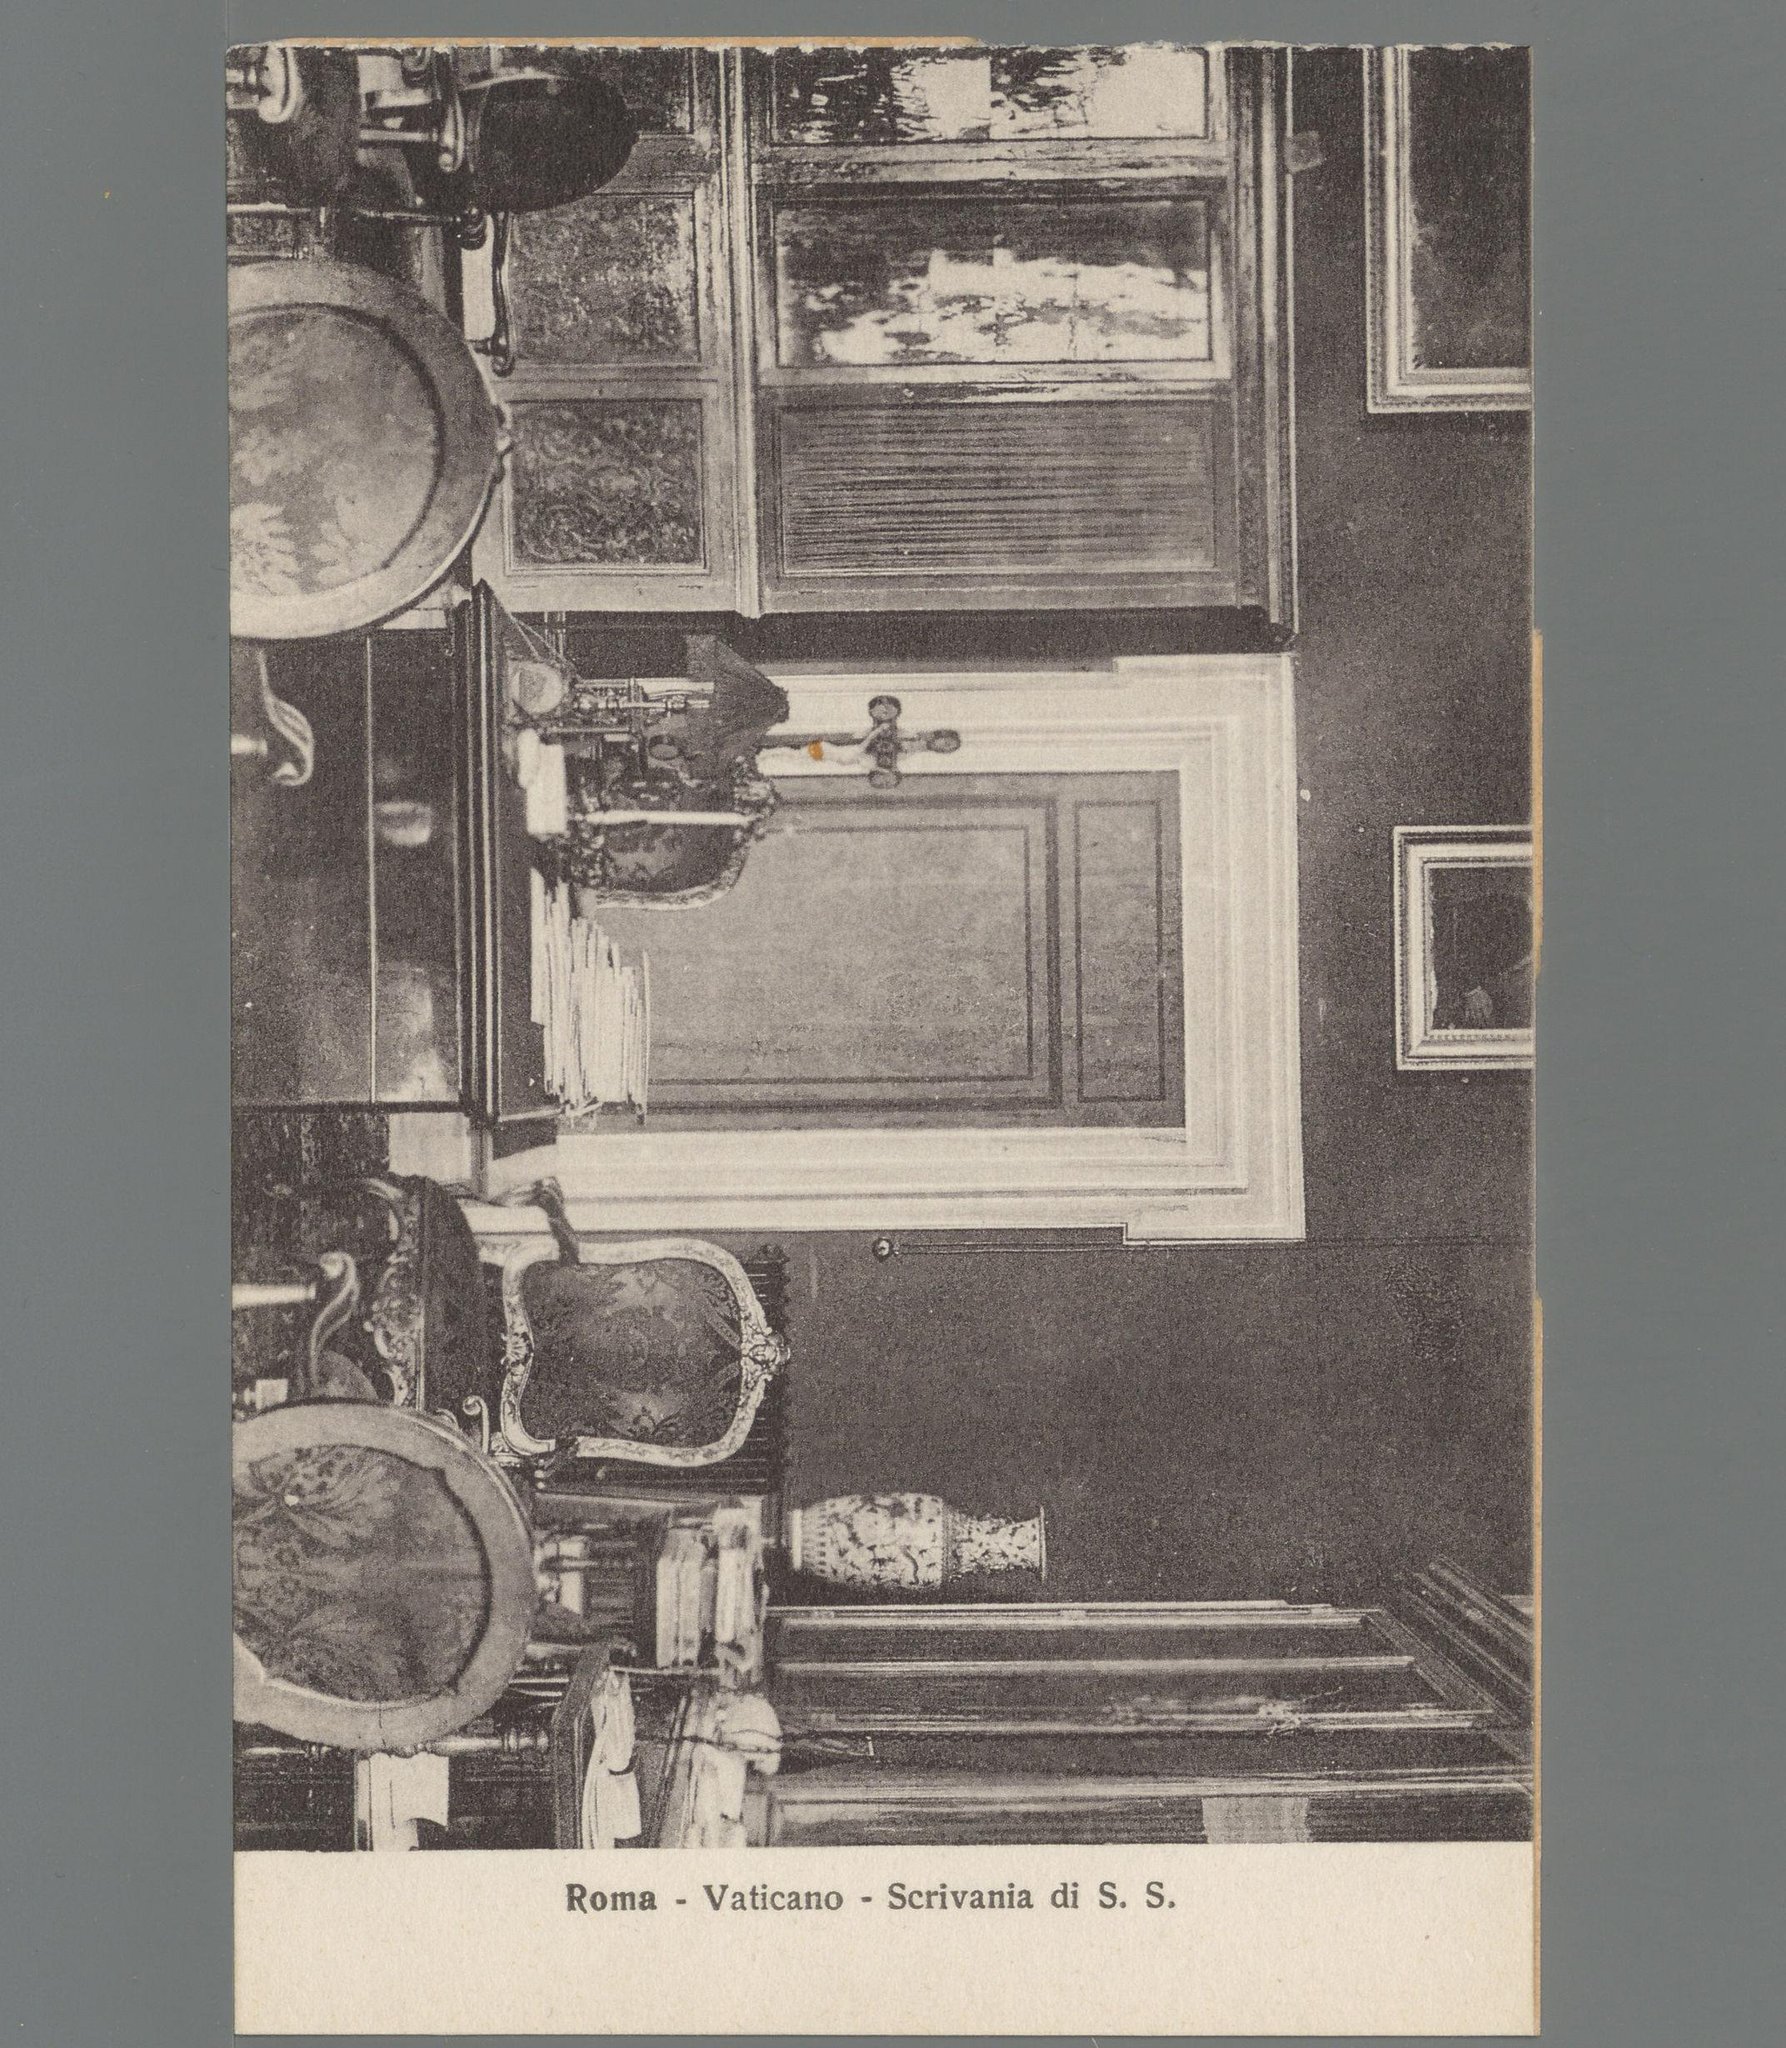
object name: ansichtkaart, prentbriefkaart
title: Roma. Vaticano. Scrivania di S.S.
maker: Anonymous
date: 1910-1930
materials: cardboard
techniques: photograph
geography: terni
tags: palace - aa - civic architecture: inside, study; 'studiolo'; library